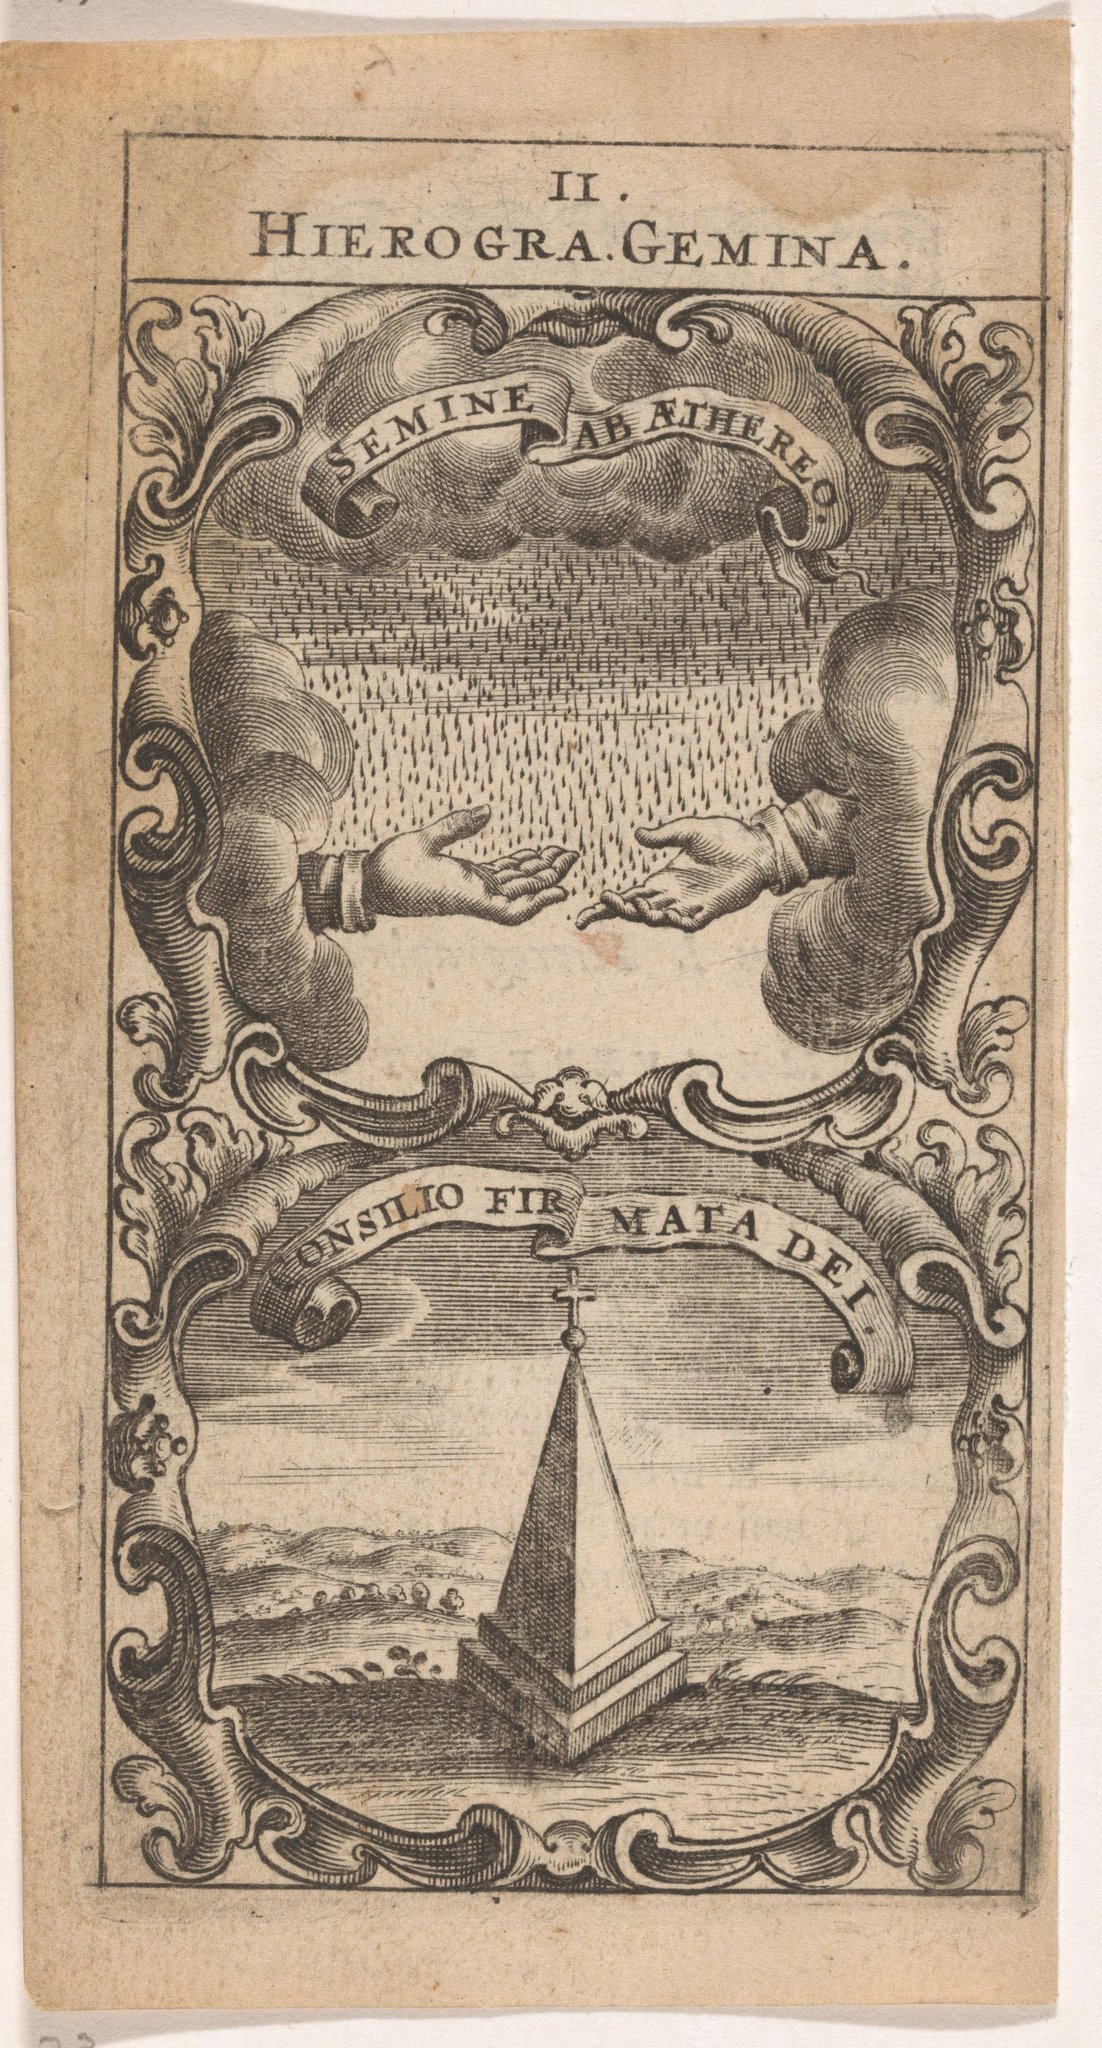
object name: print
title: Twee handen vangen de regen / Heilige piramide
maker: Anonymous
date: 1666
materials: paper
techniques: engraving, letterpress printing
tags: postures and gestures of arms and hands in general, rain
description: Pagina uit Jacob Typotius, Symbola Divina & Humana Pontificum Imperatorum Regum. Arnhem, J.F. Hagen, 1666 of uit de titeluitgave van 1669 of 1679. Het werk van Typotius werd voor het eerst uitgegeven in 1601 met prenten van Aegidius Sadeler.